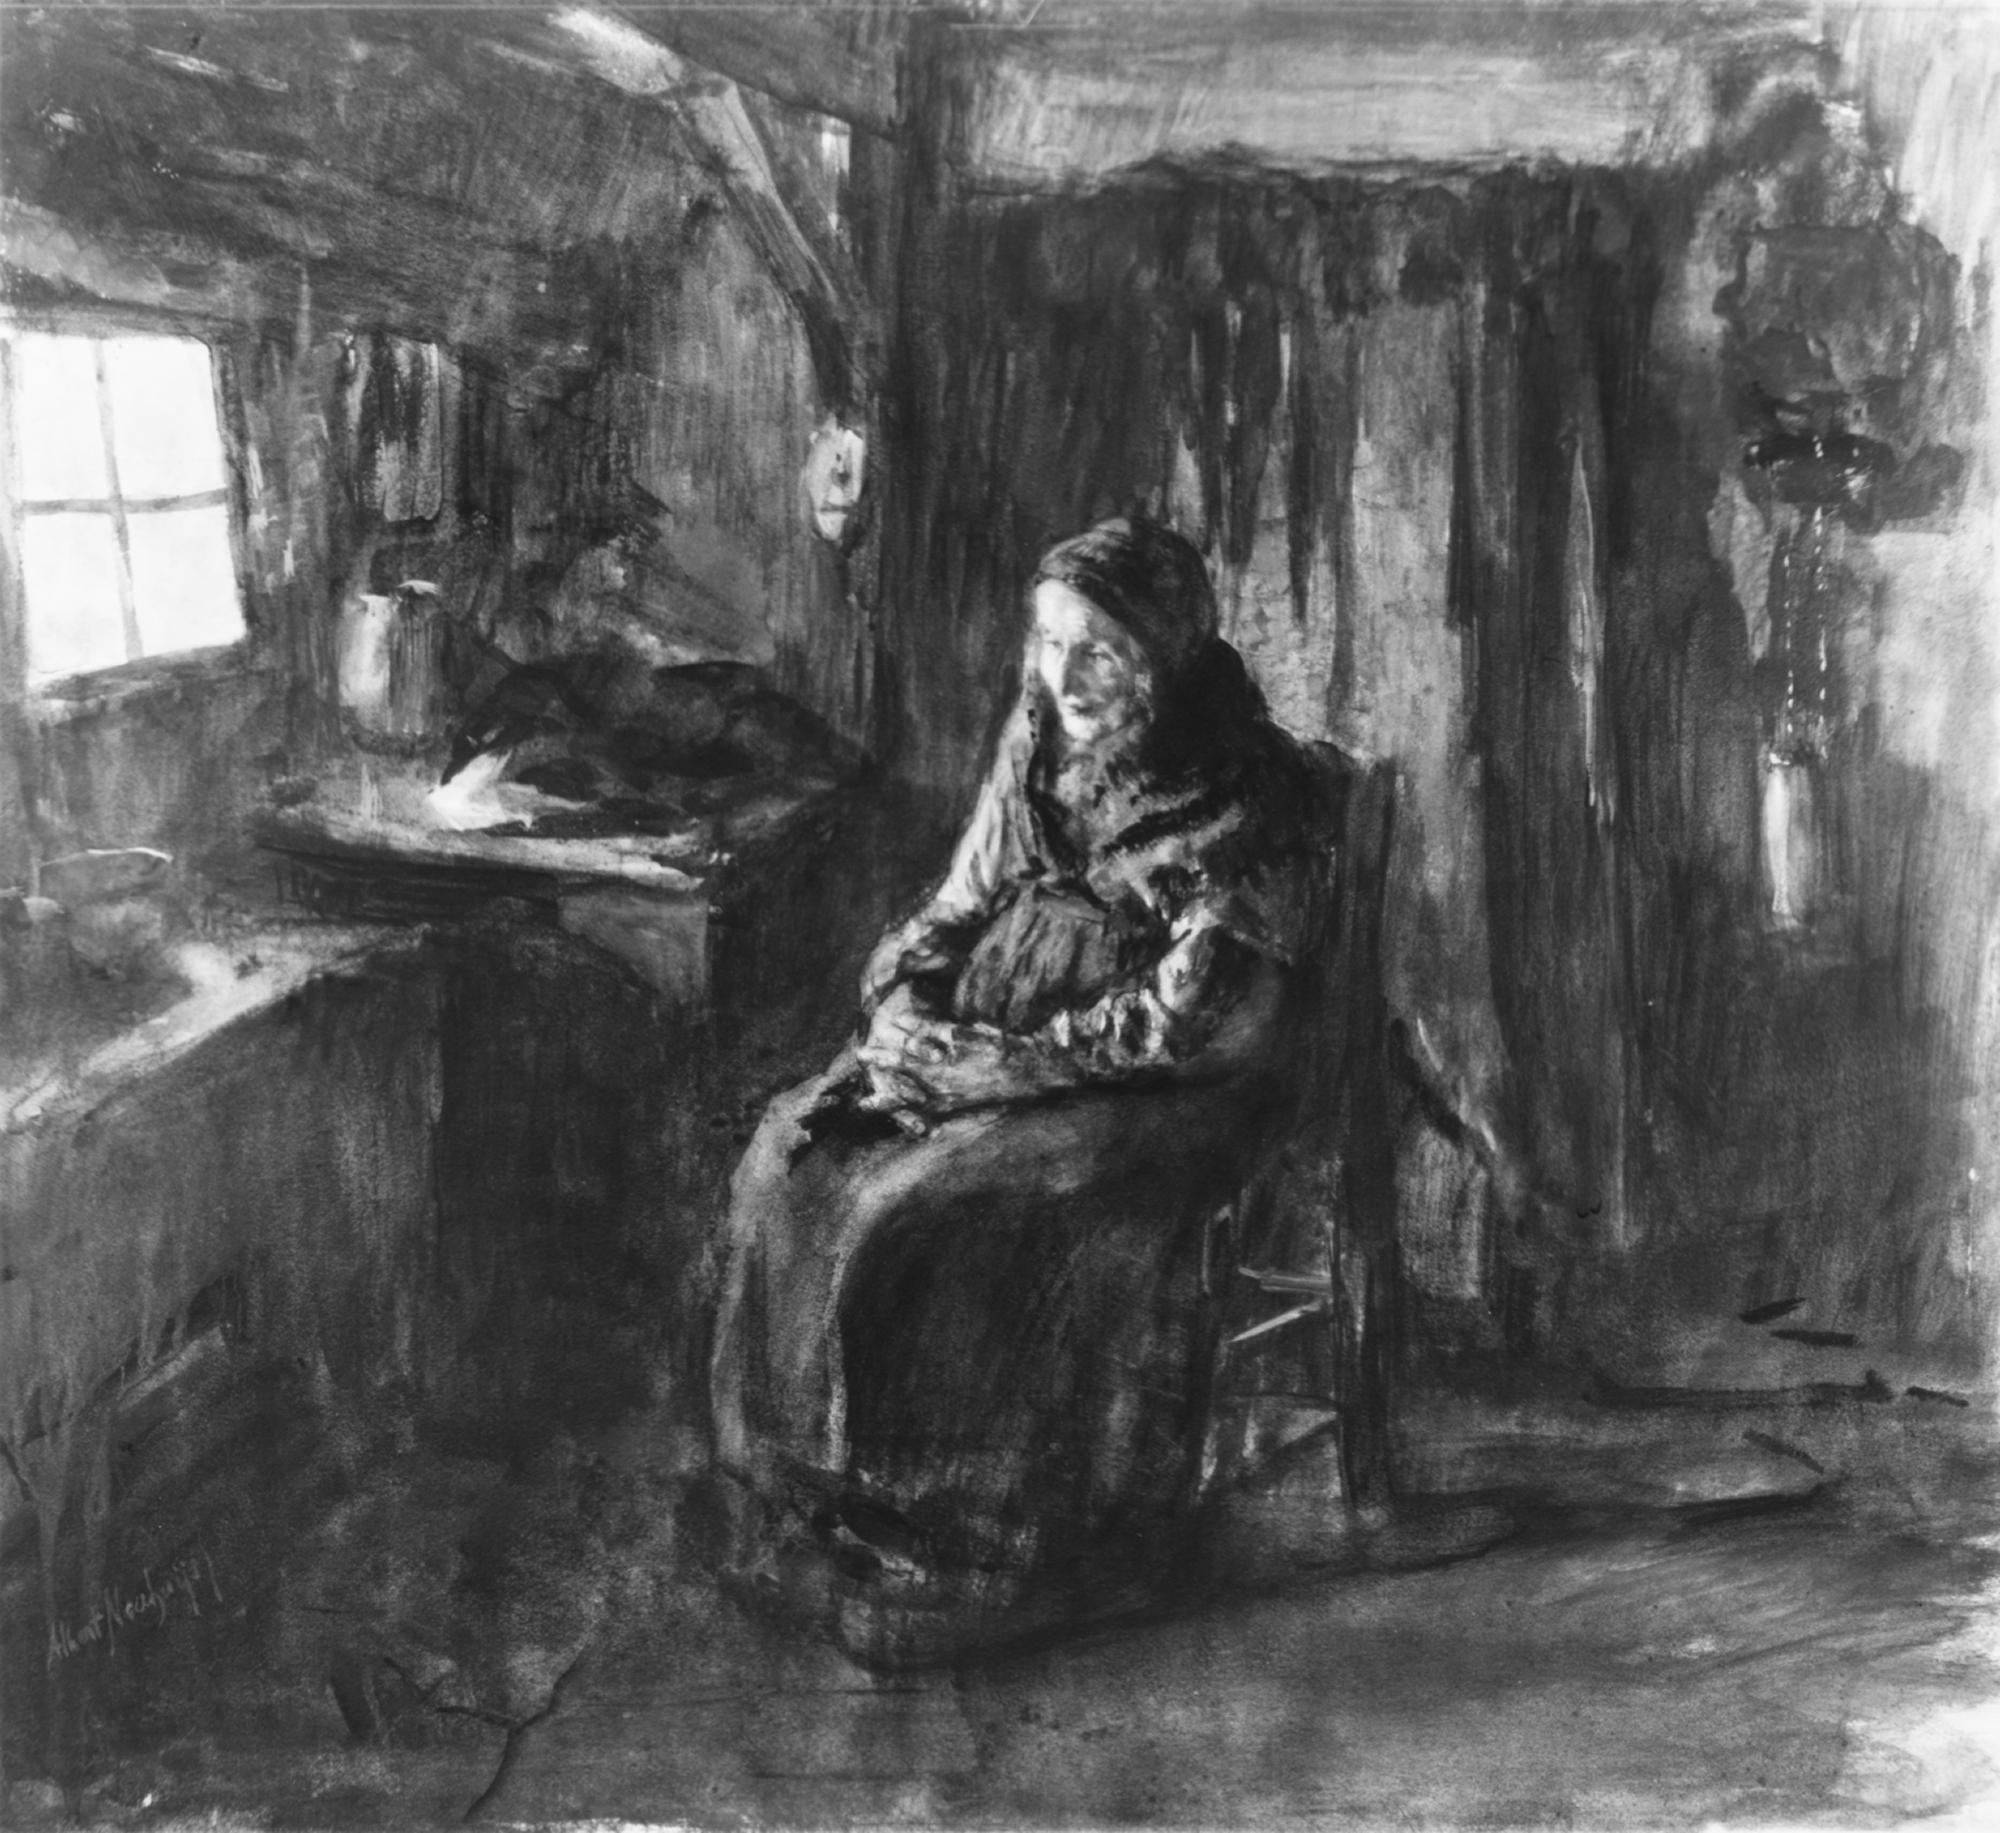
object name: drawing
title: Dutch Interior with Figure of Old Woman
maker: albert neuhuys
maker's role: artist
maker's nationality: dutch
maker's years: 1844-1914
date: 1834-1933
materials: watercolor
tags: interiors,women,chairs